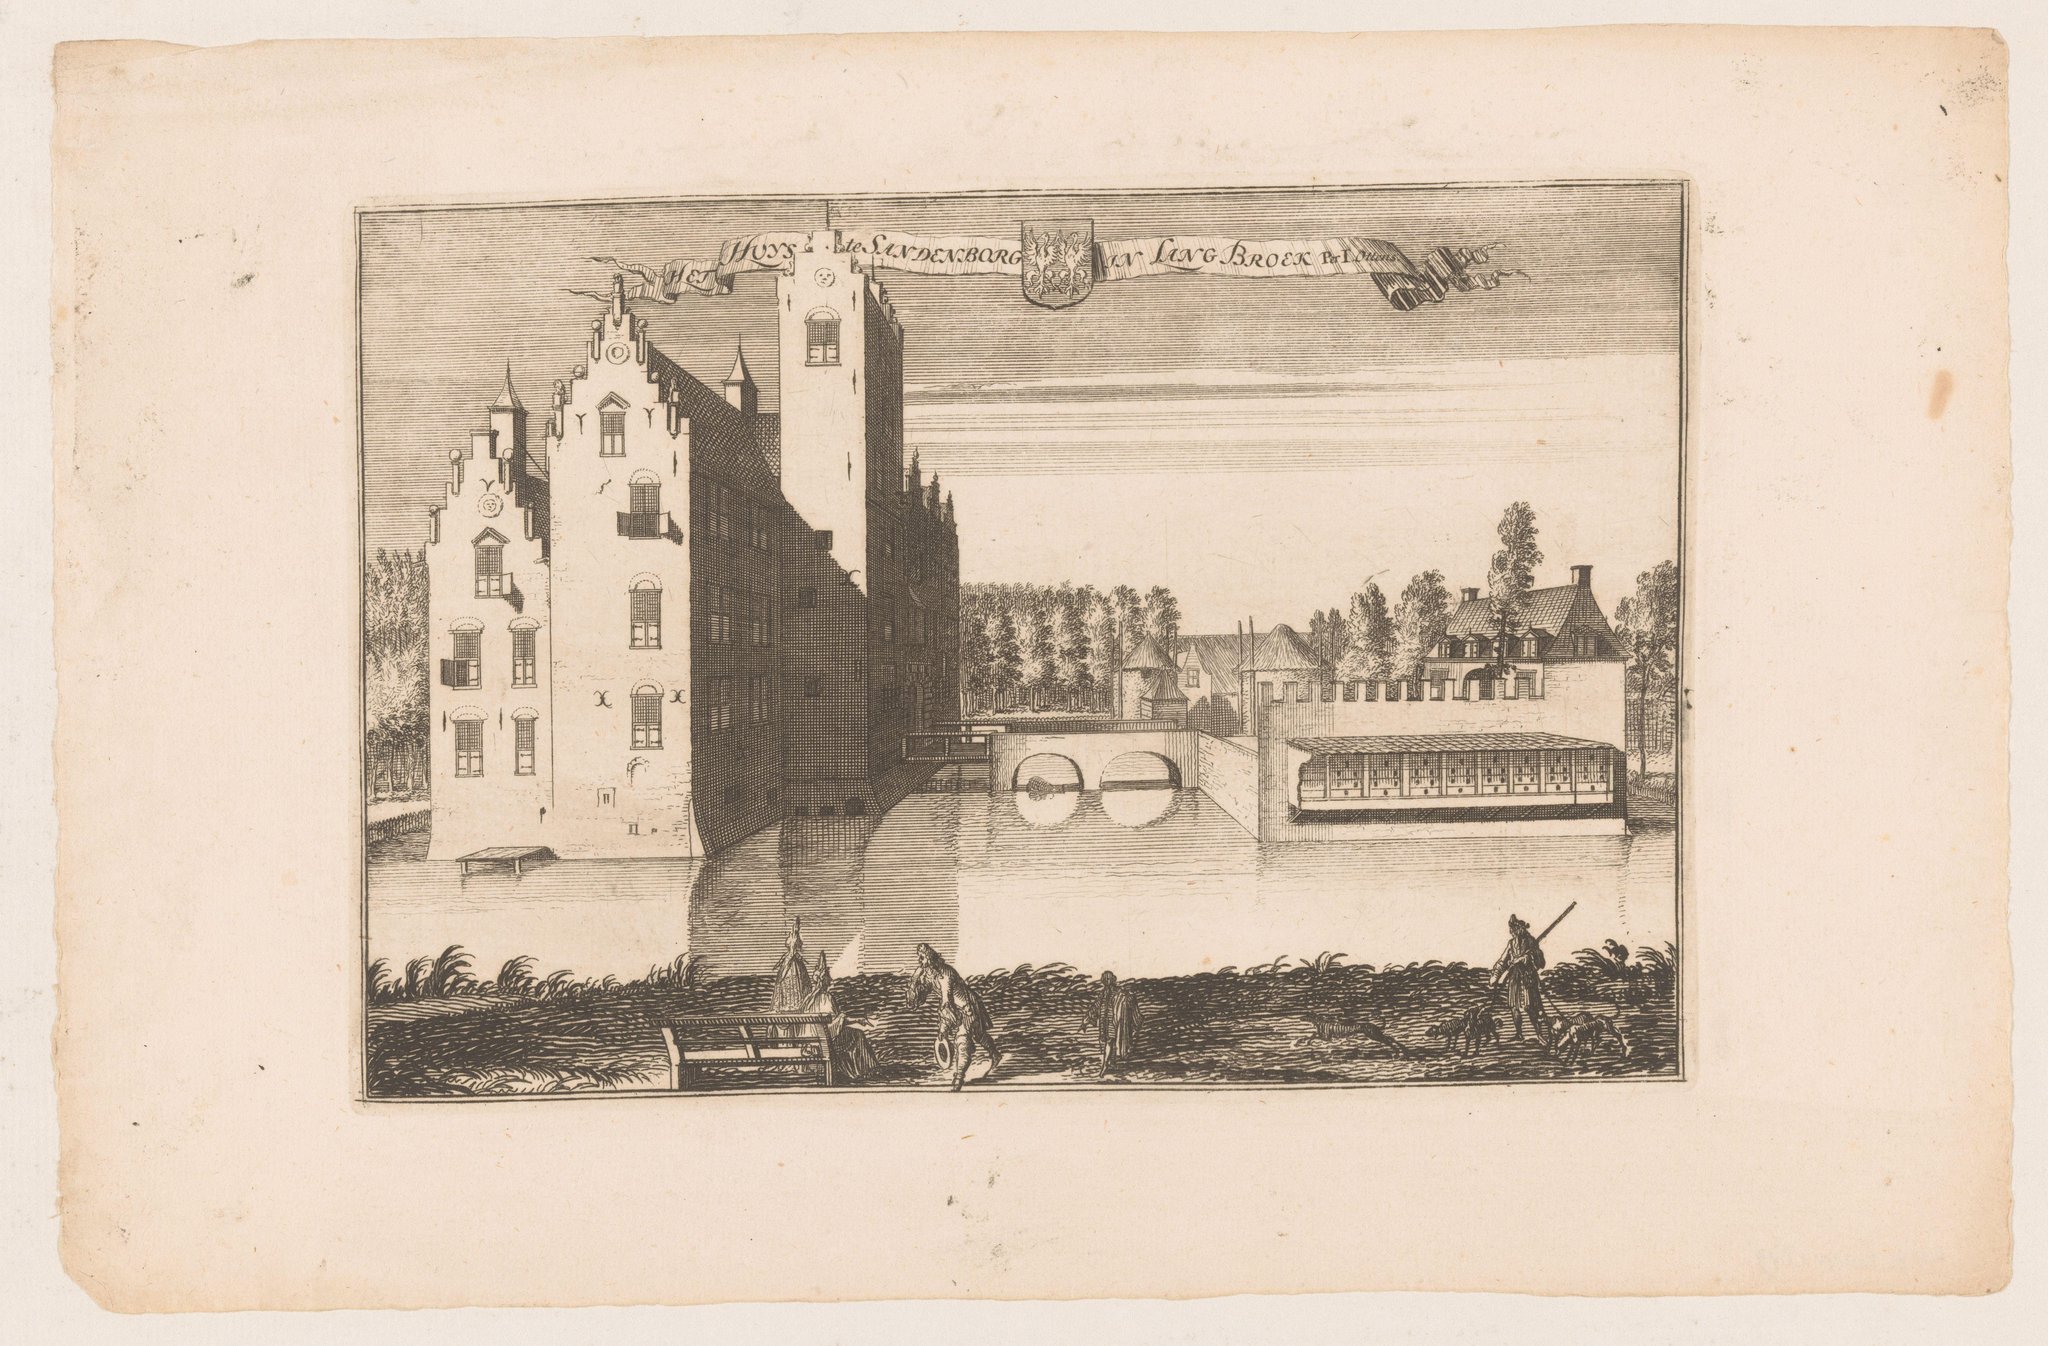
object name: print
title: Het Huys te Sandenborg in Lang Broek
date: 1730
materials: paper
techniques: engraving, etching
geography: amsterdam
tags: castle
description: Prent gebruikt in: Het verheerlykt Utrecht vertoont in de afbeeldingen der adelijke en riddermatige hofsteden, in de heerlijkheid Utrecht. Amsterdam: R. en J. Ottens, [ca. 1730]. Toeschrijvingen zijn gebaseerd op de prentmaker van en de gemaakte tekeningen in de publicatie.